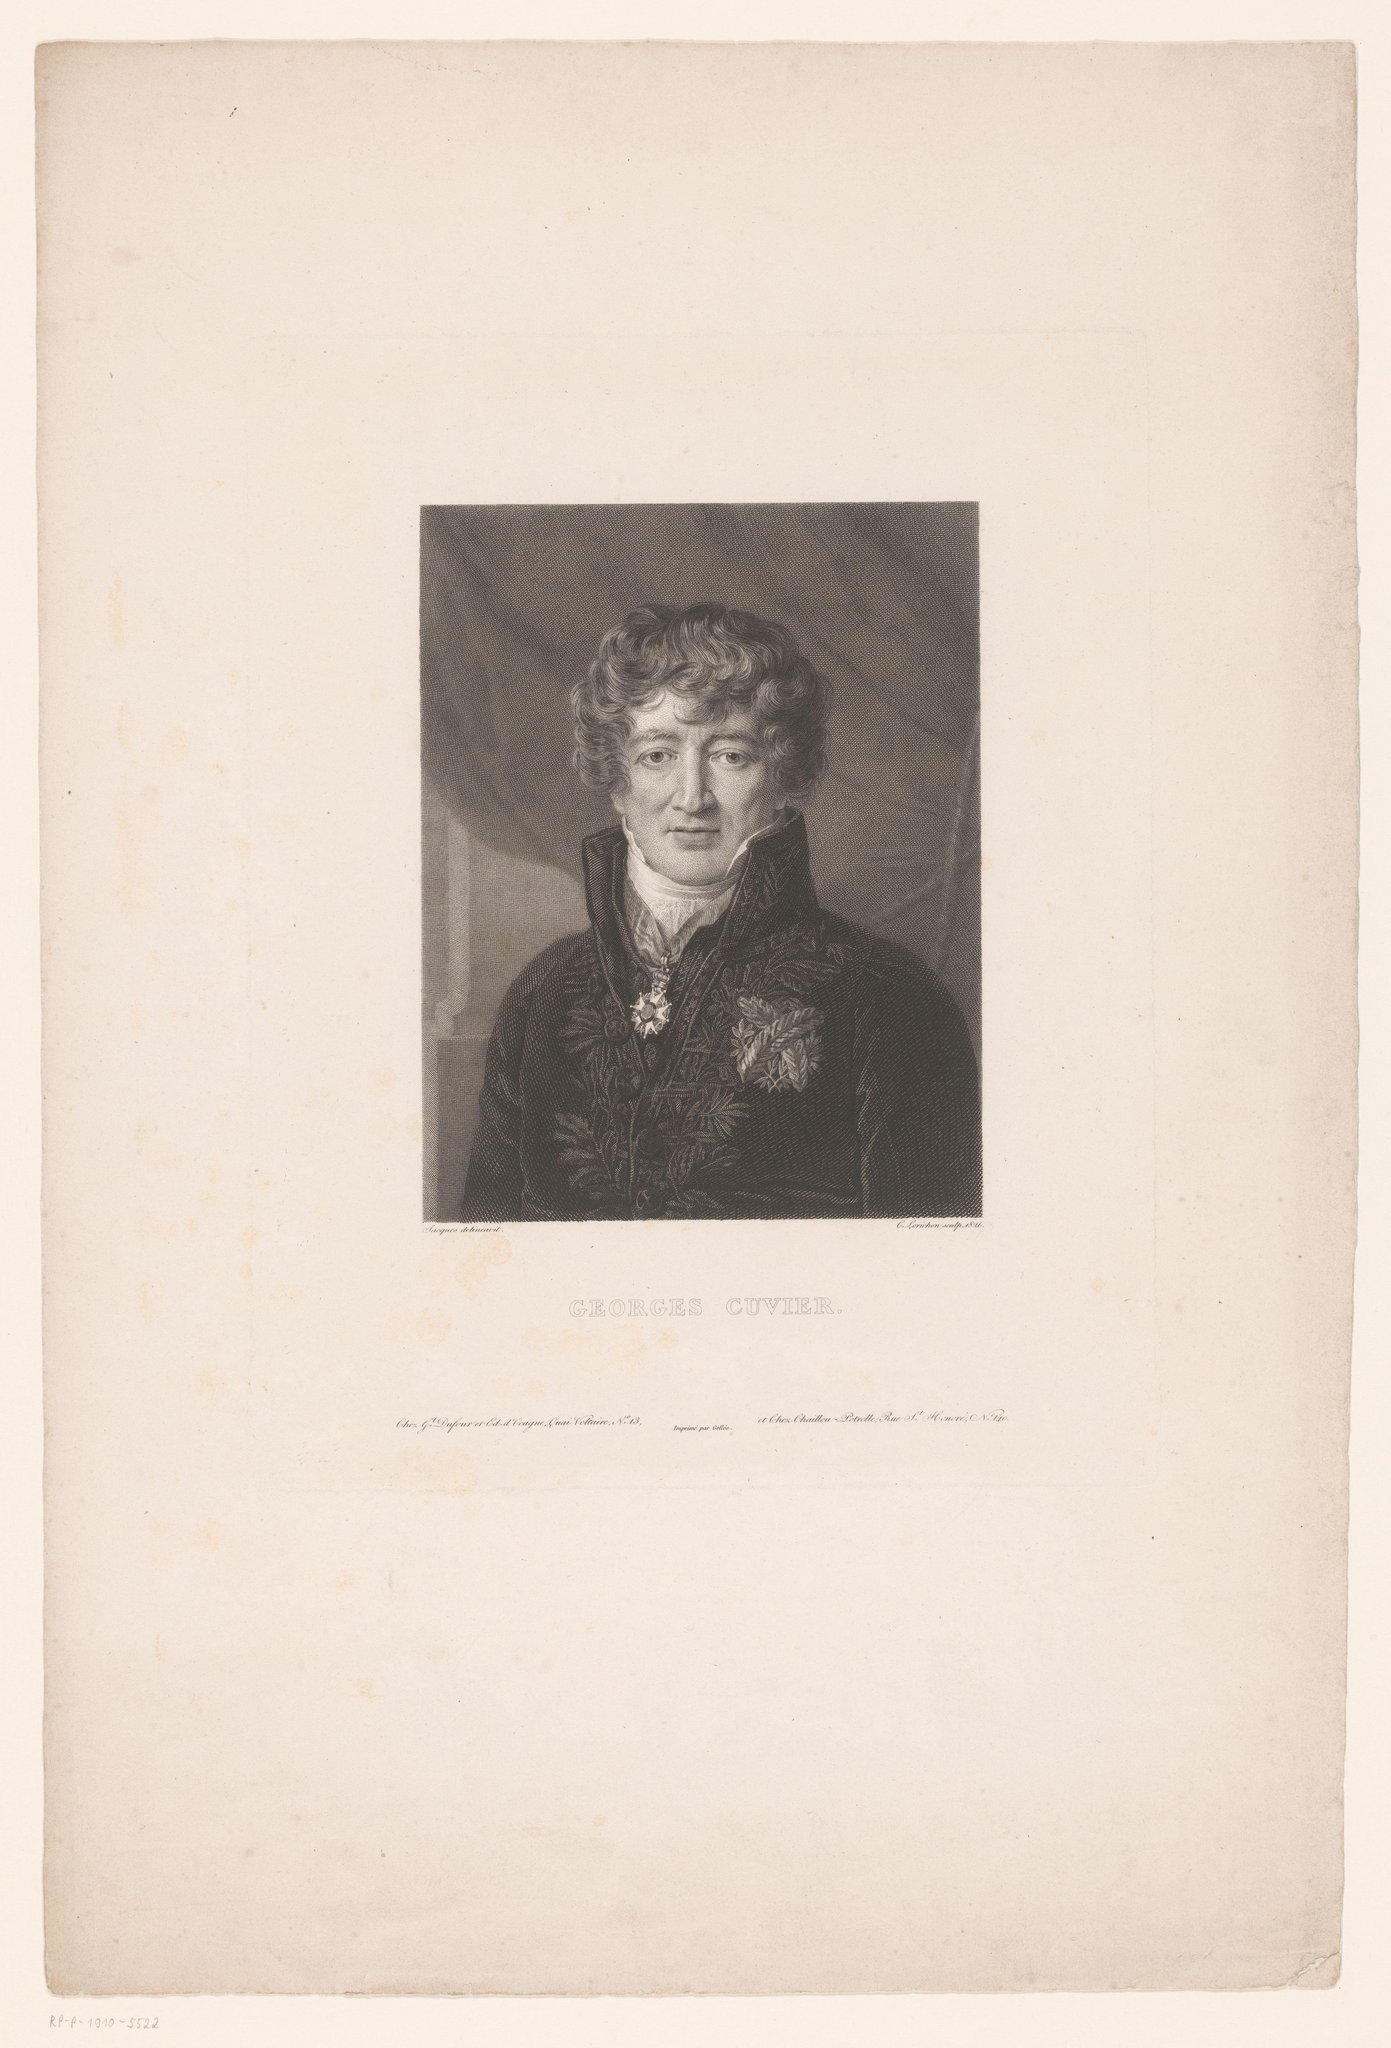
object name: print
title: Georges Cuvier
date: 1826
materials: paper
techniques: engraving, etching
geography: paris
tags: paris, historical persons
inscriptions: collector's mark: Lugt 2228